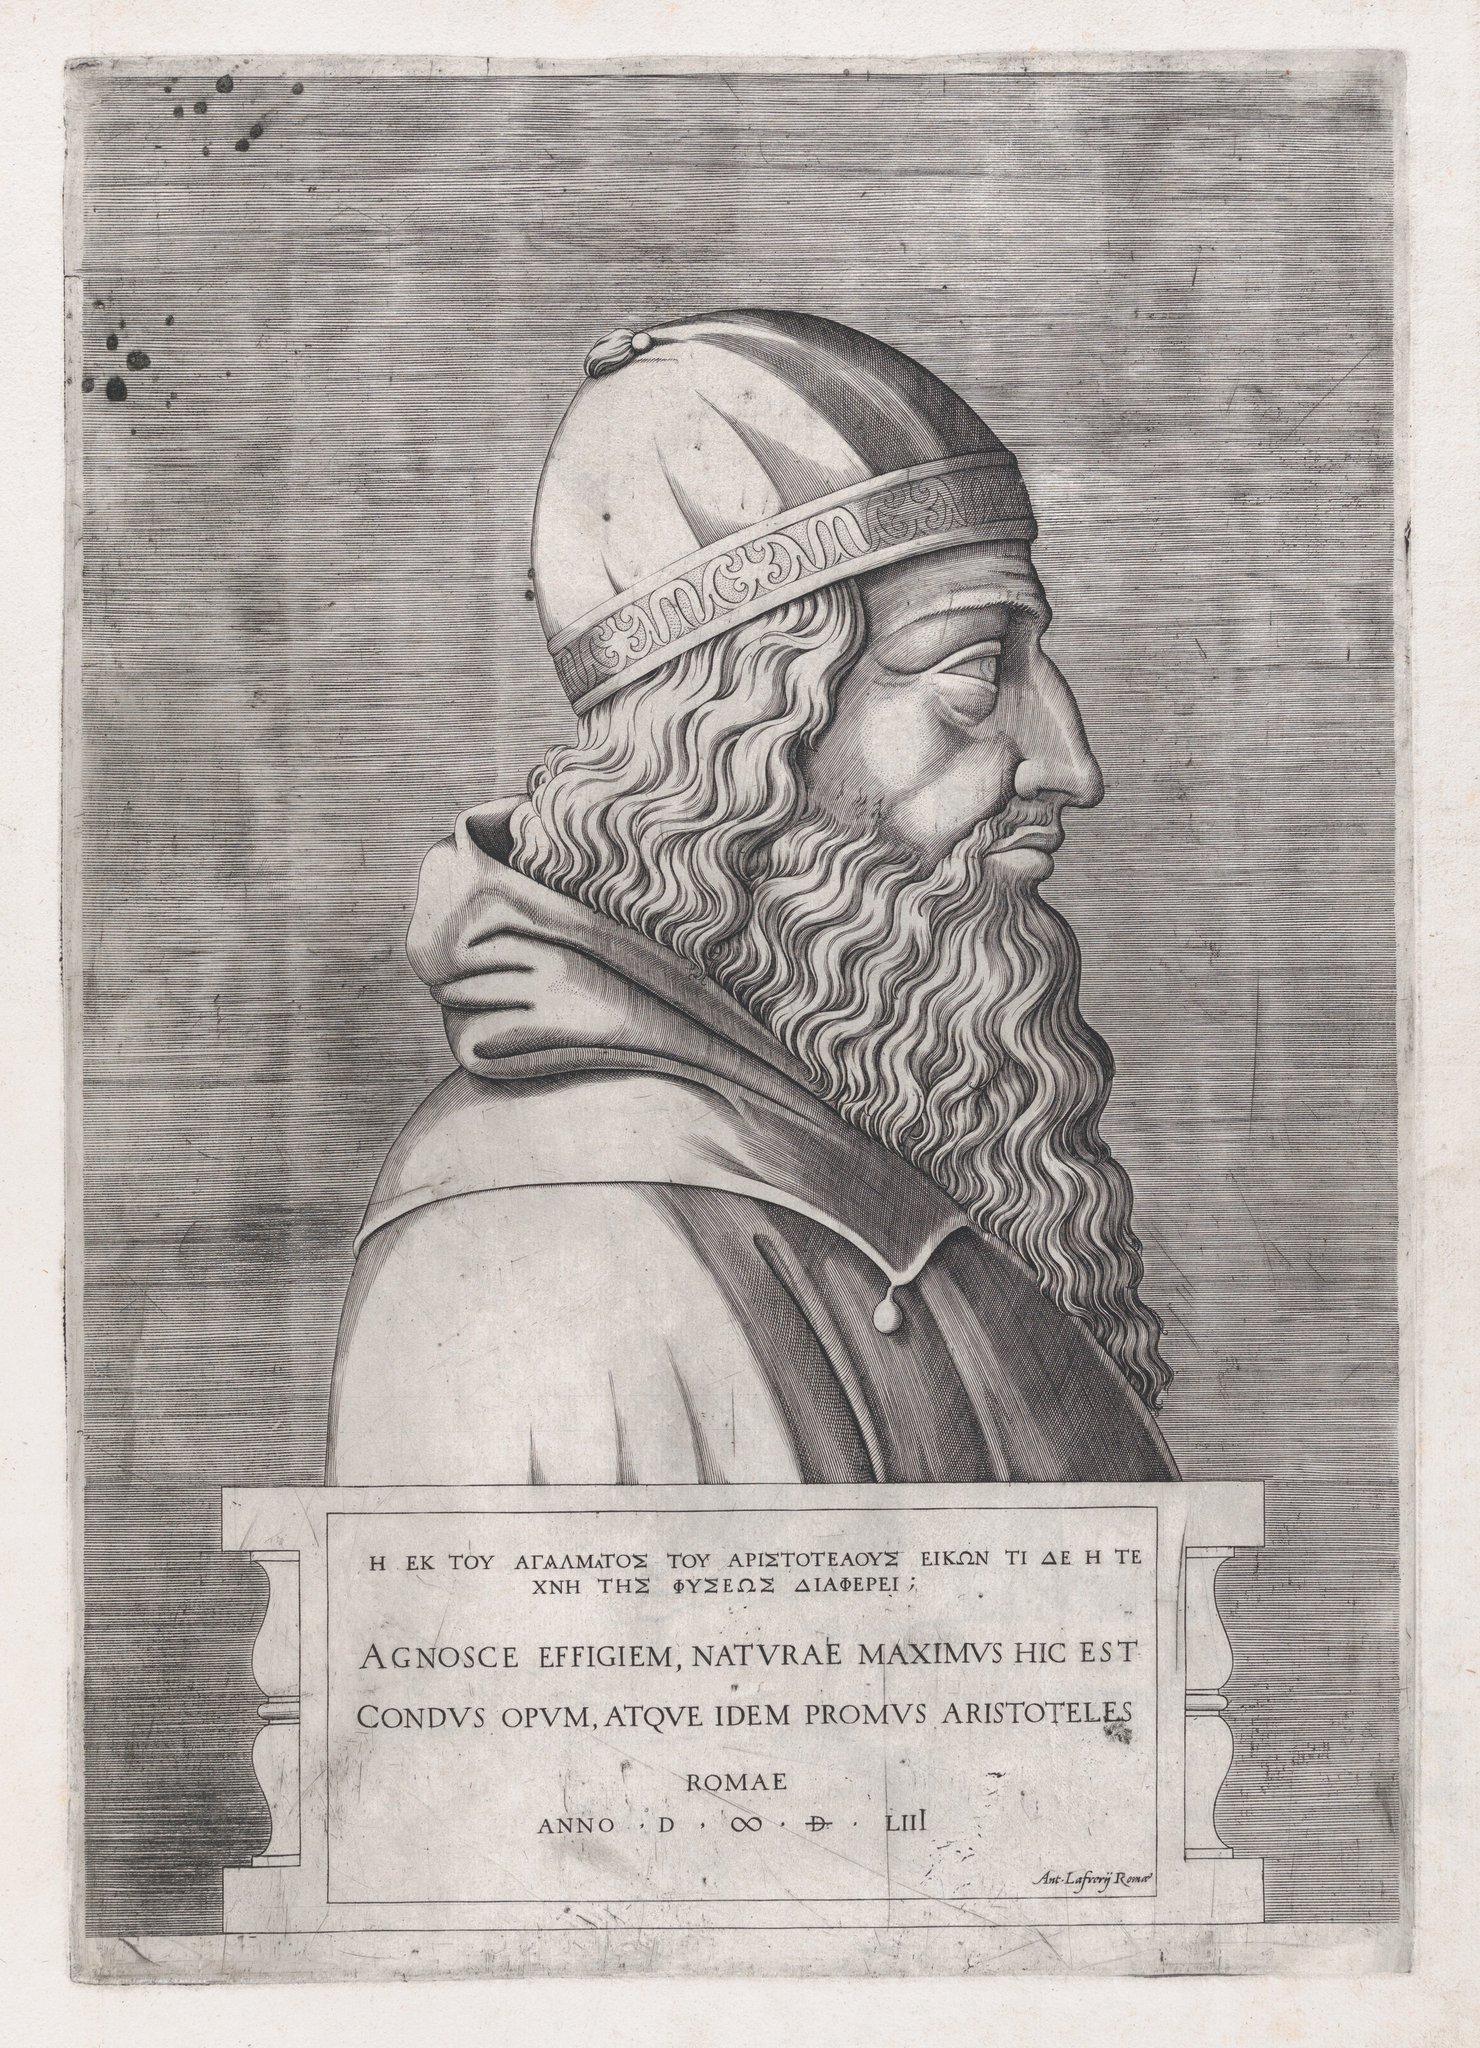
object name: print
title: Aristotle, from "Speculum Romanae Magnificentiae"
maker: anonymous, italian, mid-16th century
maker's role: artist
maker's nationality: italian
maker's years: 1520-1580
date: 1553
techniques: engraving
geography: rome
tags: aristotle,profiles